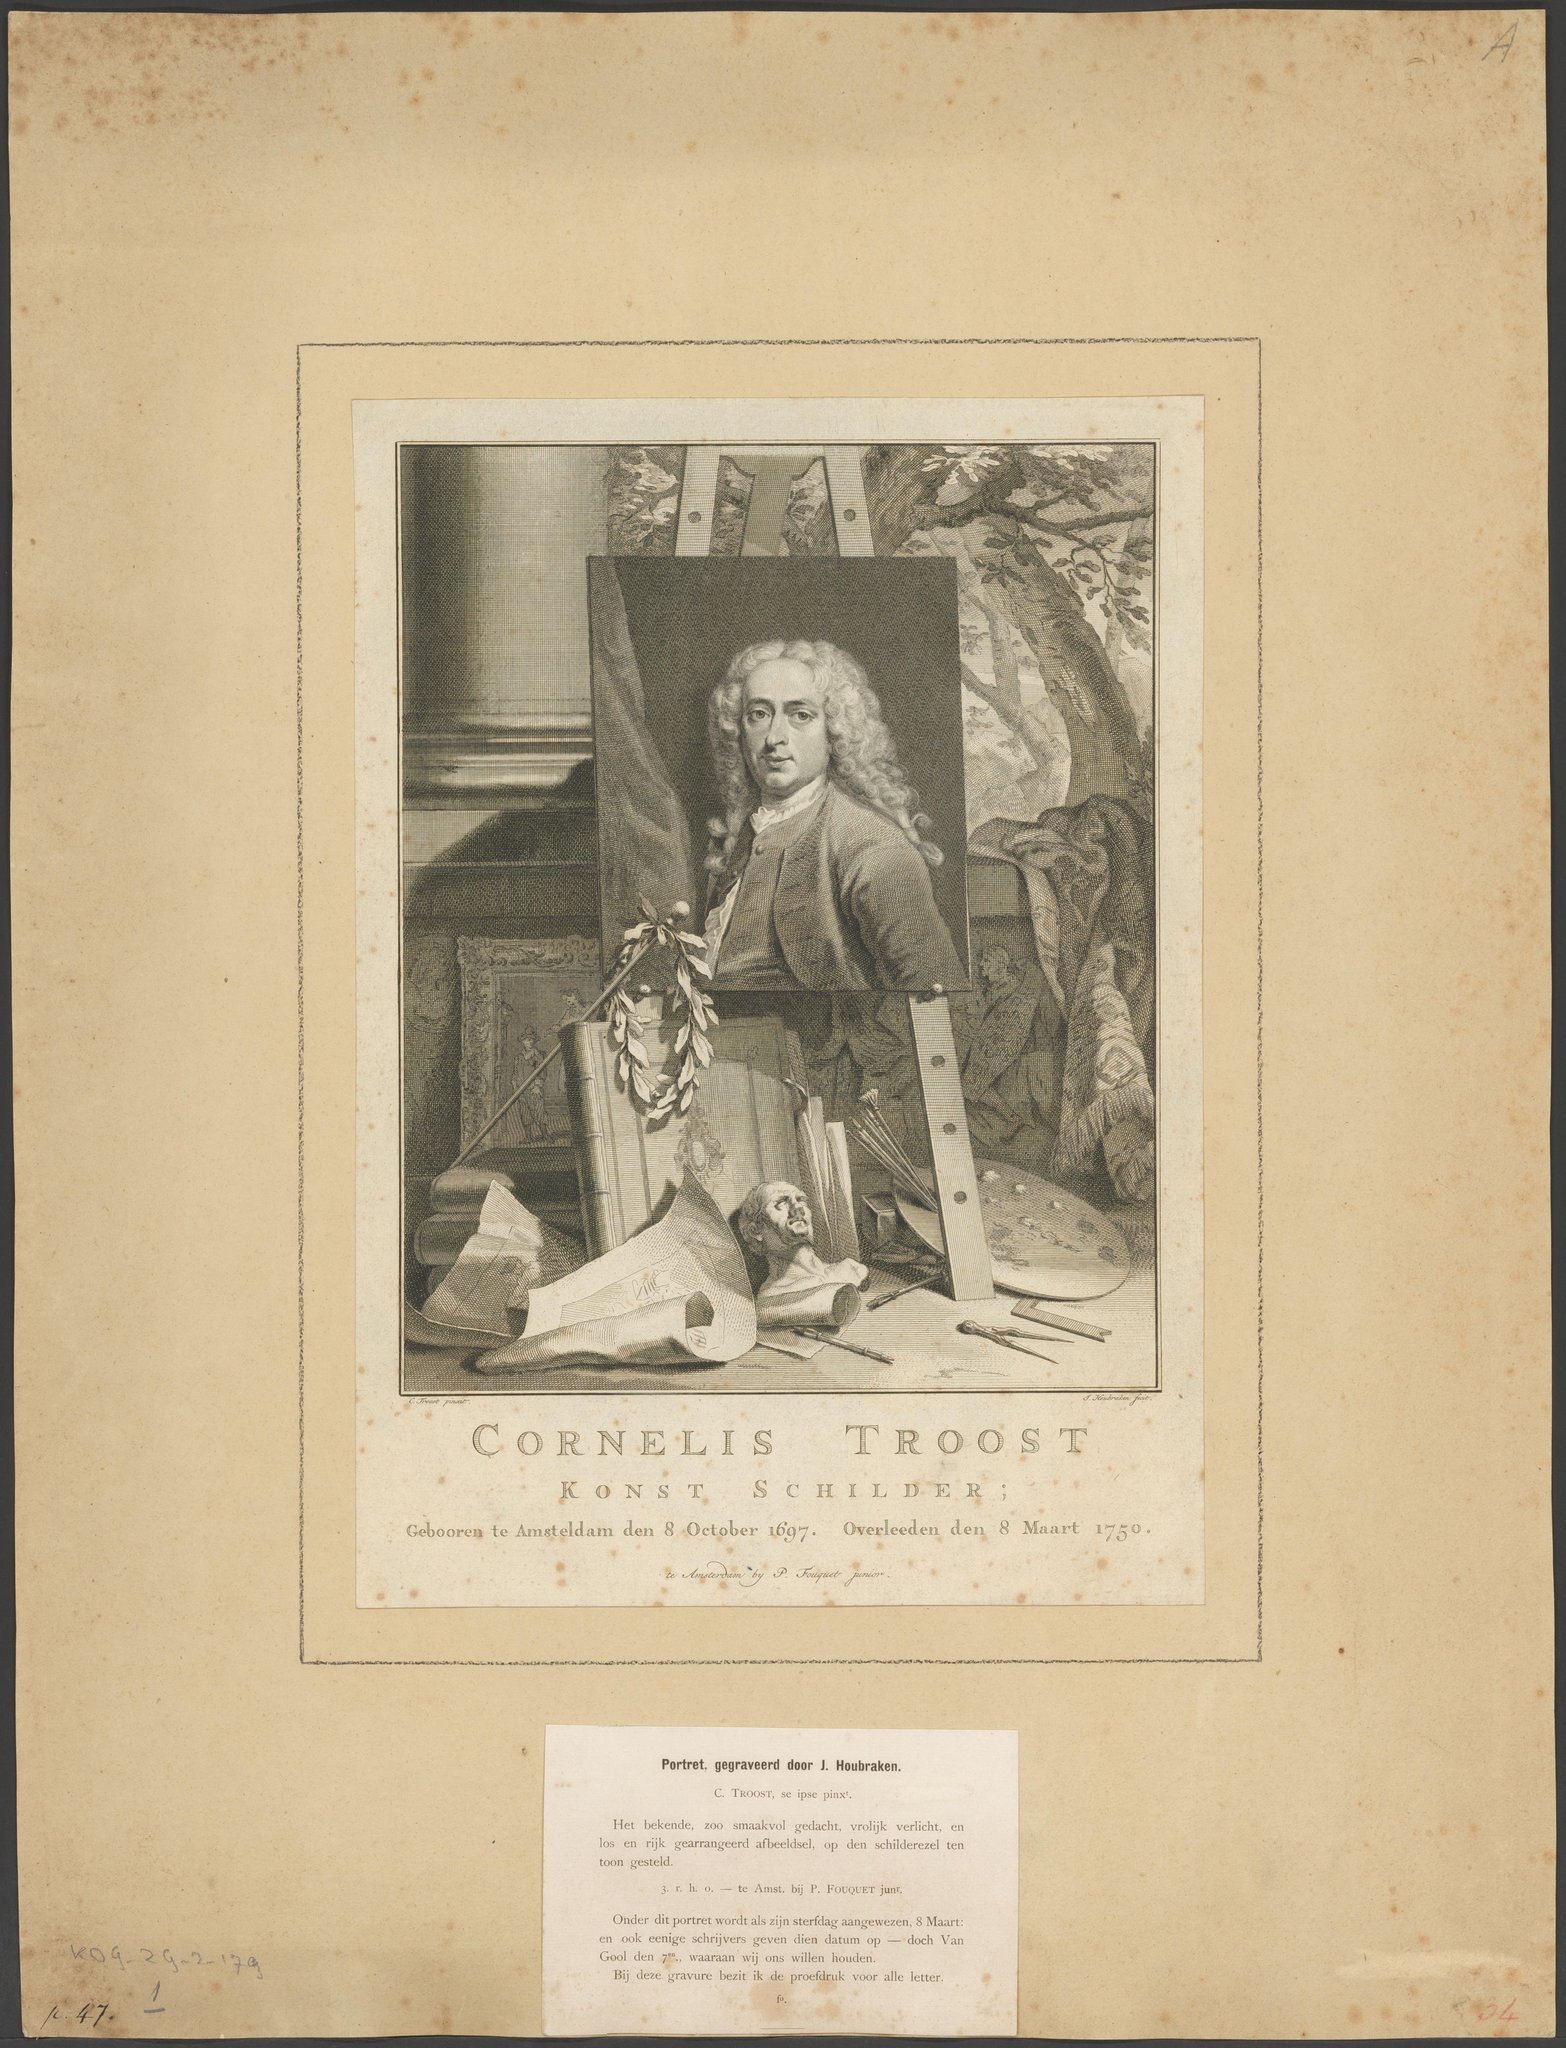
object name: print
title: Cornelis Troost Konst Schilder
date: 1760-1780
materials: paper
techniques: engraving, etching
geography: amsterdam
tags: amsterdam, painter, print maker, draughtsman, cornelis troost, historical persons, portrait, self-portrait of painter, portrait, self-portrait of artist, palette, wig, brushes ~ implements of painter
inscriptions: collector's mark: Lugt 2488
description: Portret van de schilder Cornelis Troost. Het schilderij met zijn portret staat op een schildersezel op een bordes en is omringd door de attributen van de schilder- en graveerkunst. Onder de ezel liggen palet en penselen, een gebeeldhouwde kop, tekenstiften, boeken en tekeningen. Links staat de schildersstok, waaraan een lauwerkrans hangt. Daarachter een schilderij in lijst. In de achtergrond een doorkijk naar een landschap. Gemonteerd op een blad samen met een fragment geknipt uit het boek van Ver Huell.